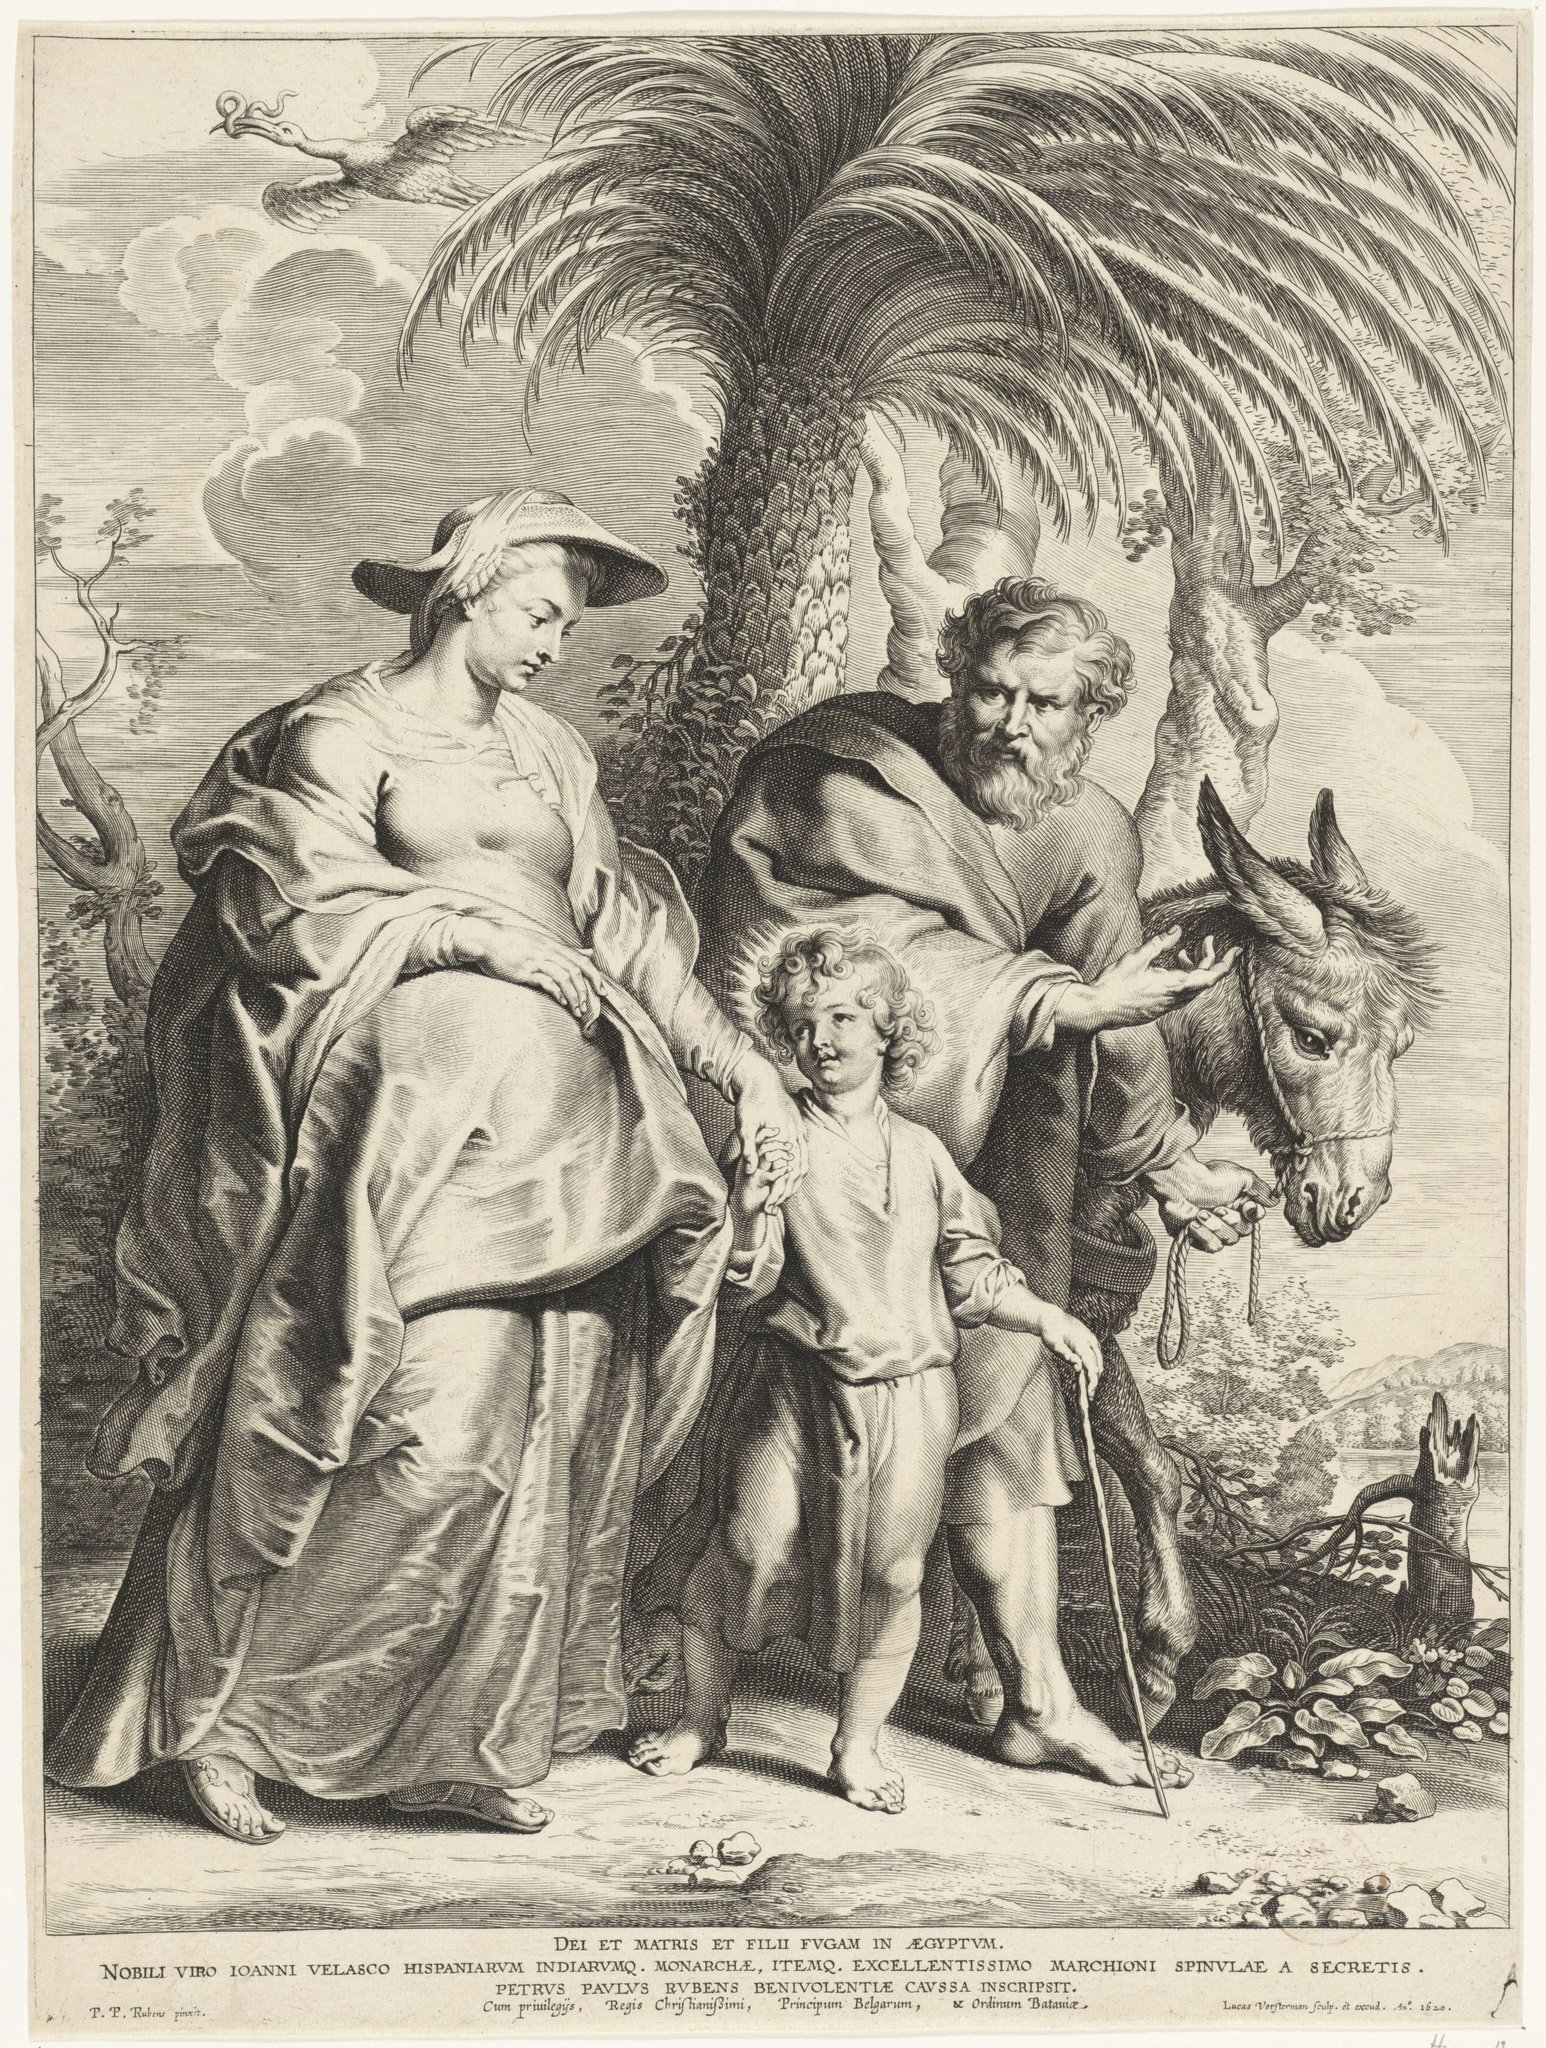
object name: print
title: Vlucht naar Egypte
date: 1620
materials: paper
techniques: engraving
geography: antwerp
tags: the flight into egypt: mary, joseph, the child (and sometimes others) on their way; mary usually riding on an ass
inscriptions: collector's mark: Lugt 240